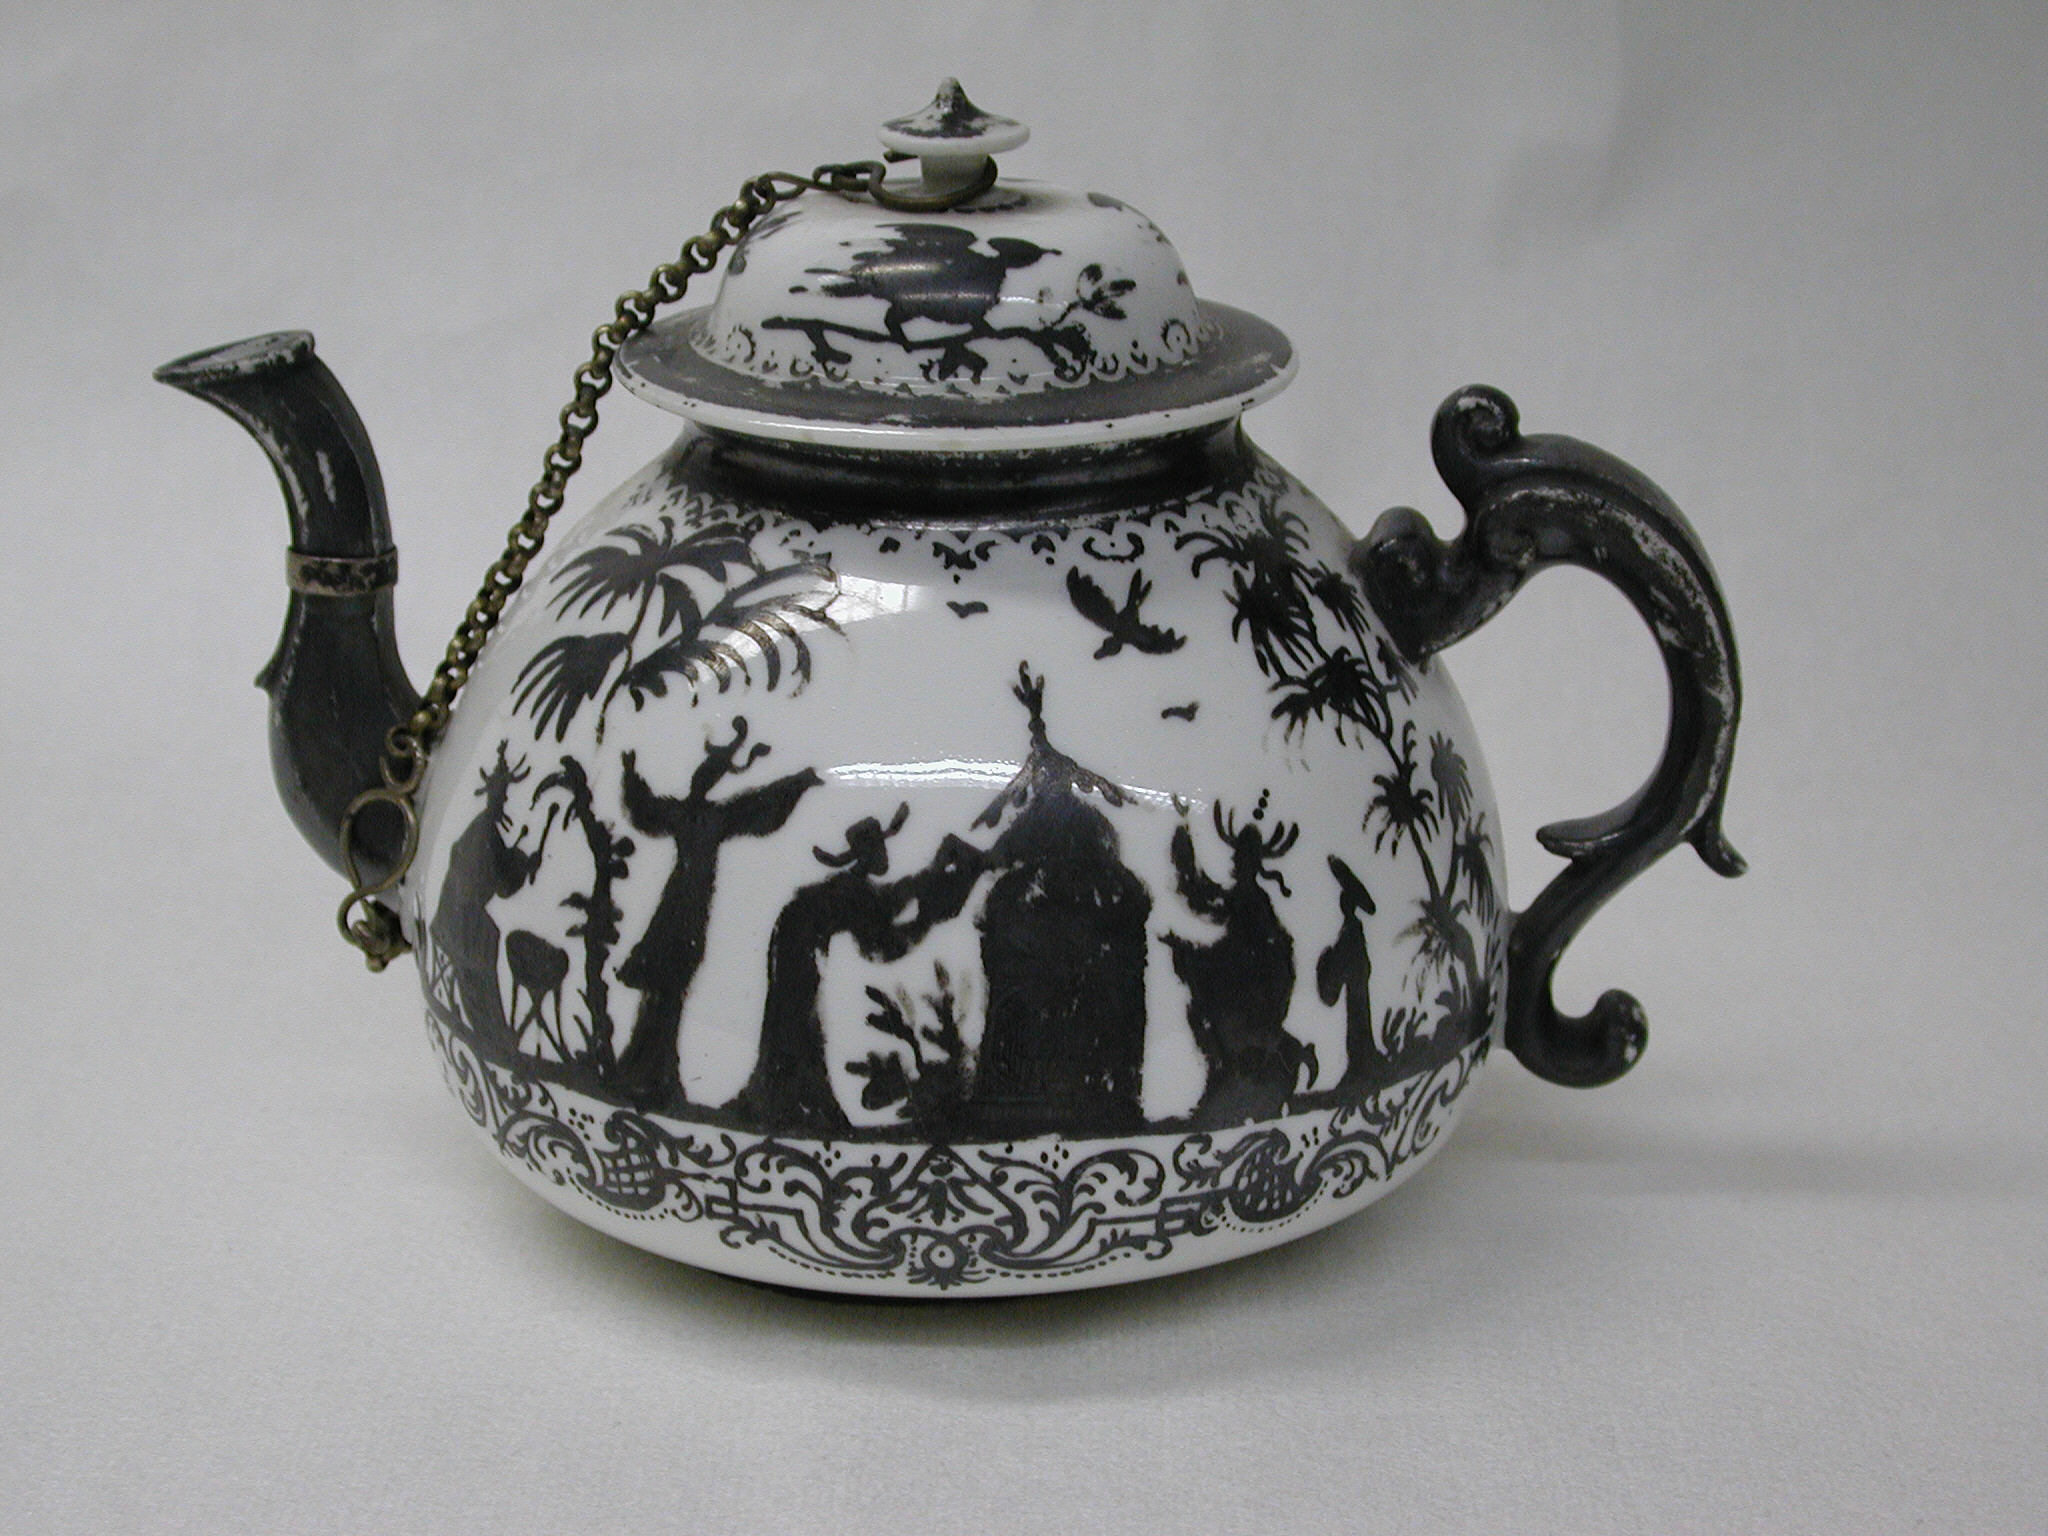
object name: teapot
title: Teapot (part of a service)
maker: meissen manufactory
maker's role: manufactory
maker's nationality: german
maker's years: 1710-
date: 1720-1725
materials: hard paste porcelain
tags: human figures,birds,plants